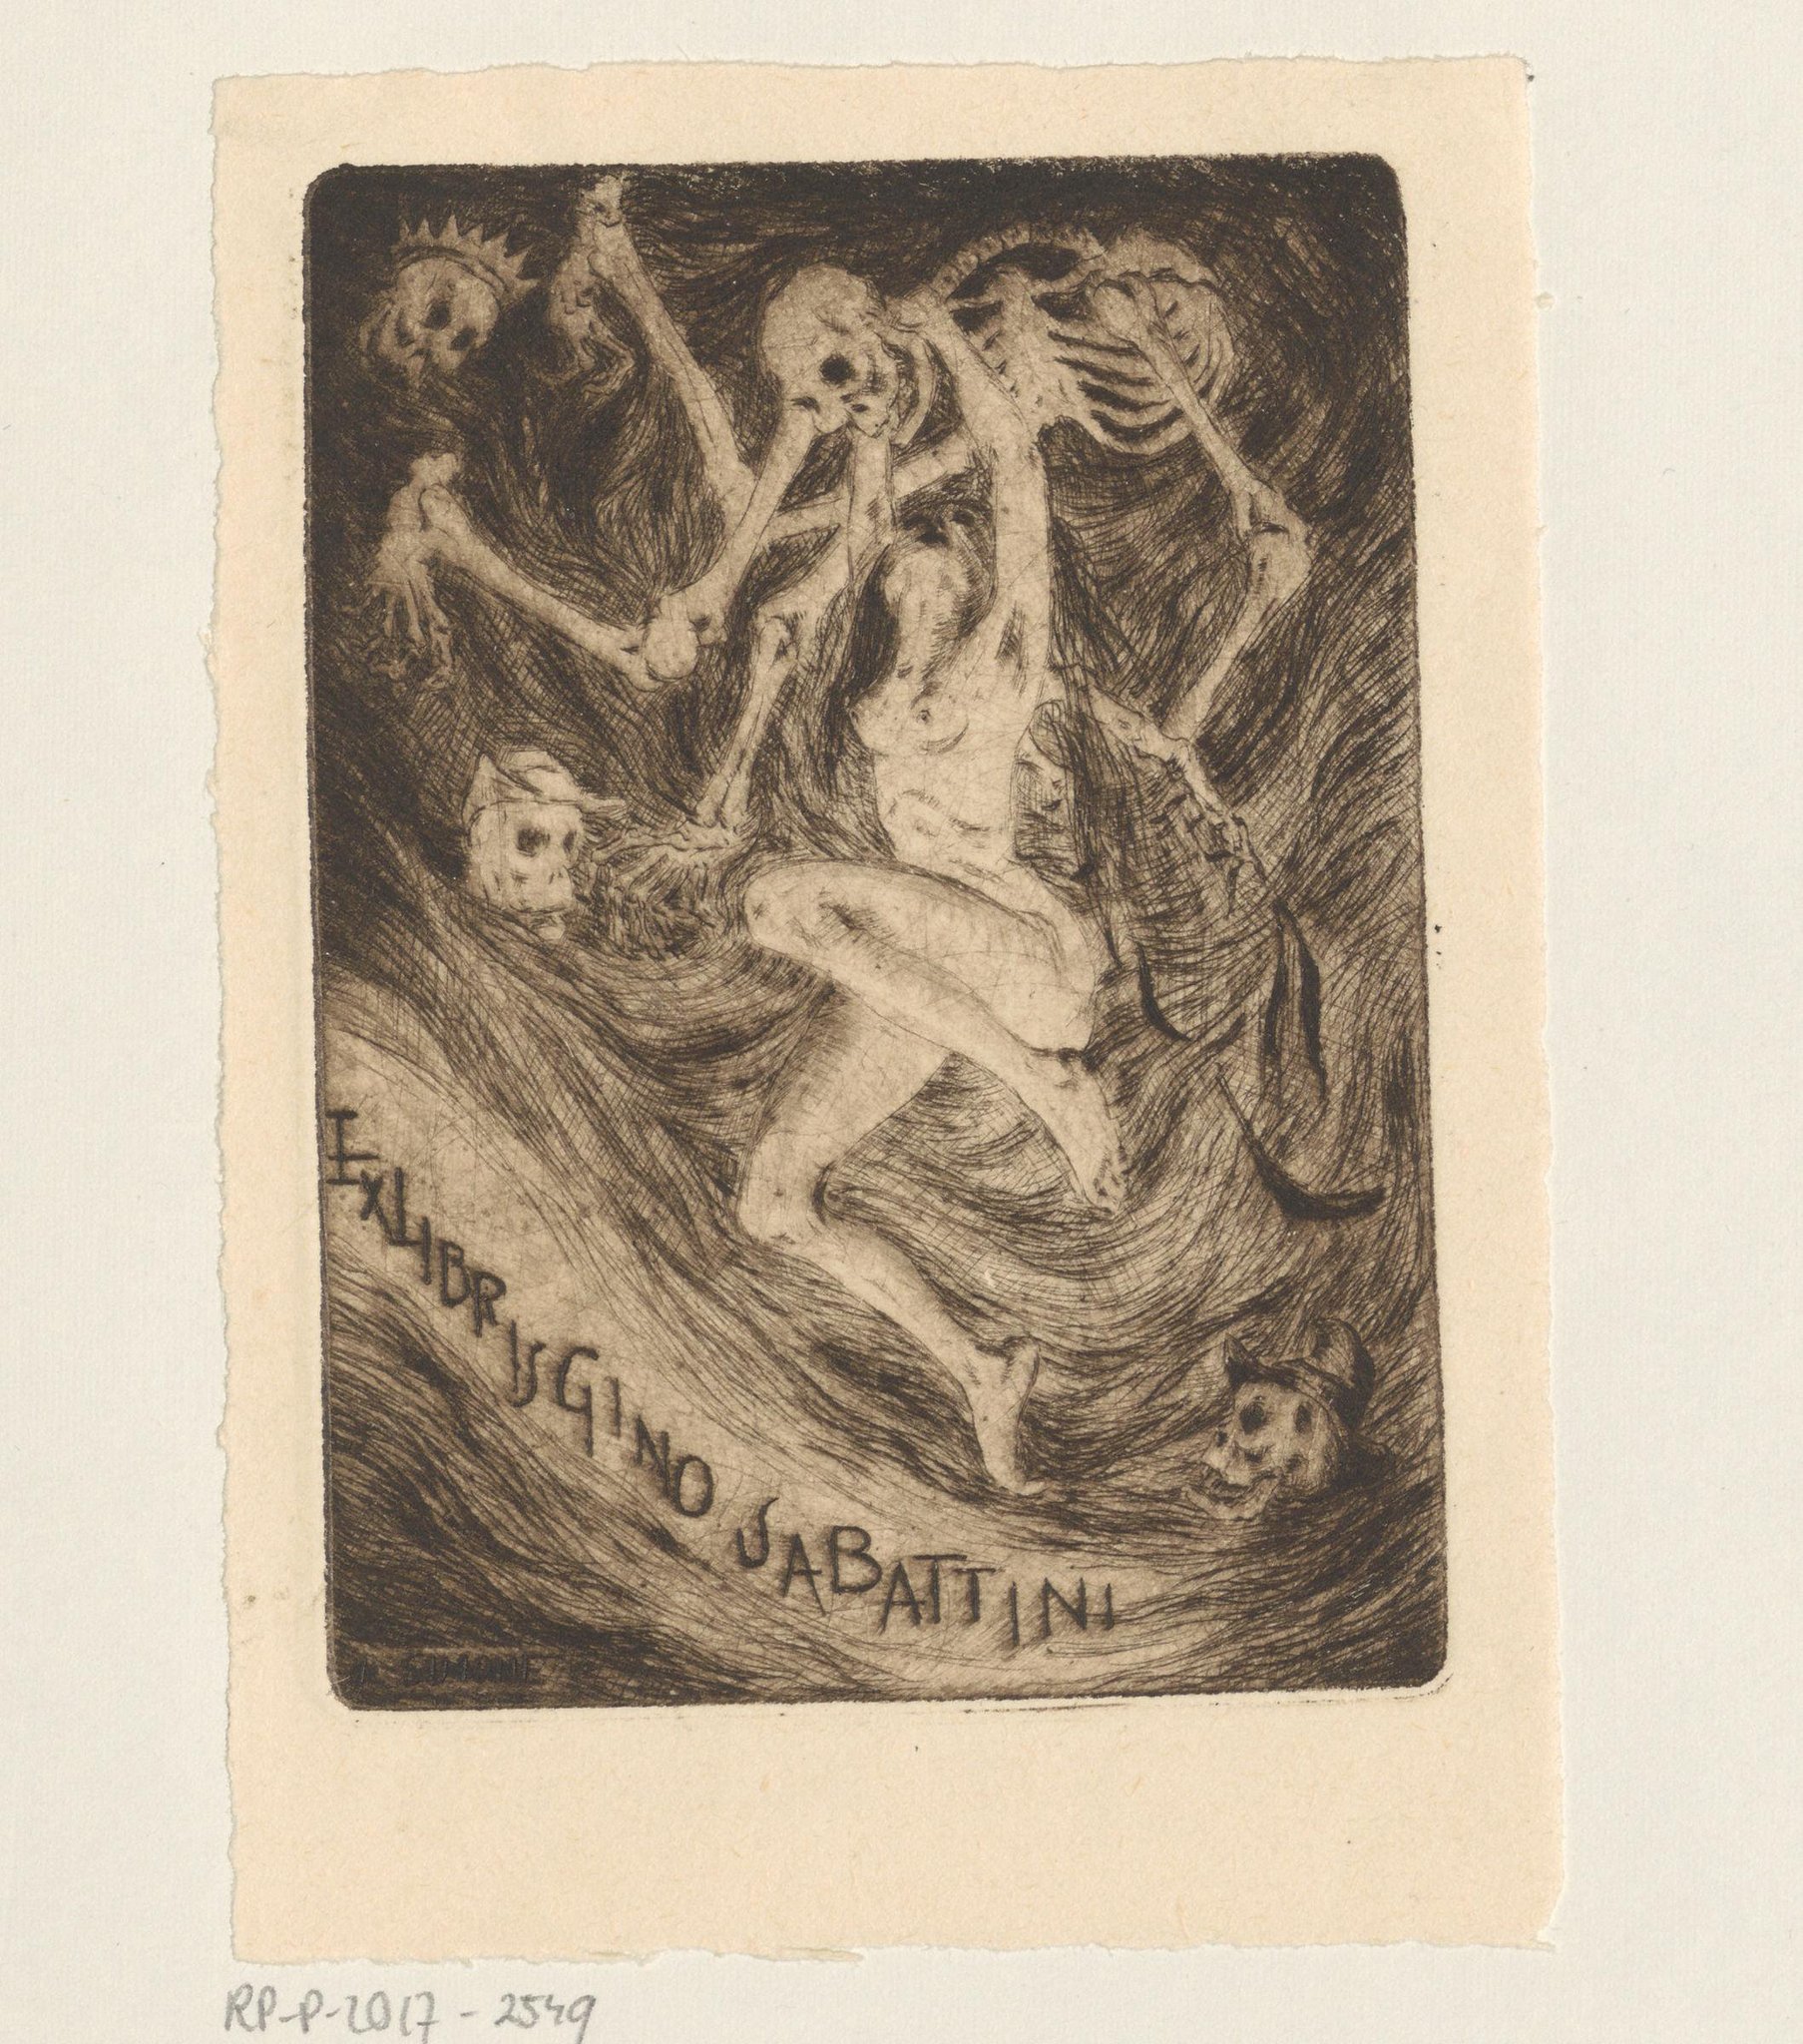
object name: bookplate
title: Ex libris van Gino Sabattini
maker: marco de simone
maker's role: print maker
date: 1949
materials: paper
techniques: drypoint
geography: italy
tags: gino sabattini, woman (showing herself) undressed, quasi-nude, (human) skeleton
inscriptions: inscription: ‘M. De Simone 1949’